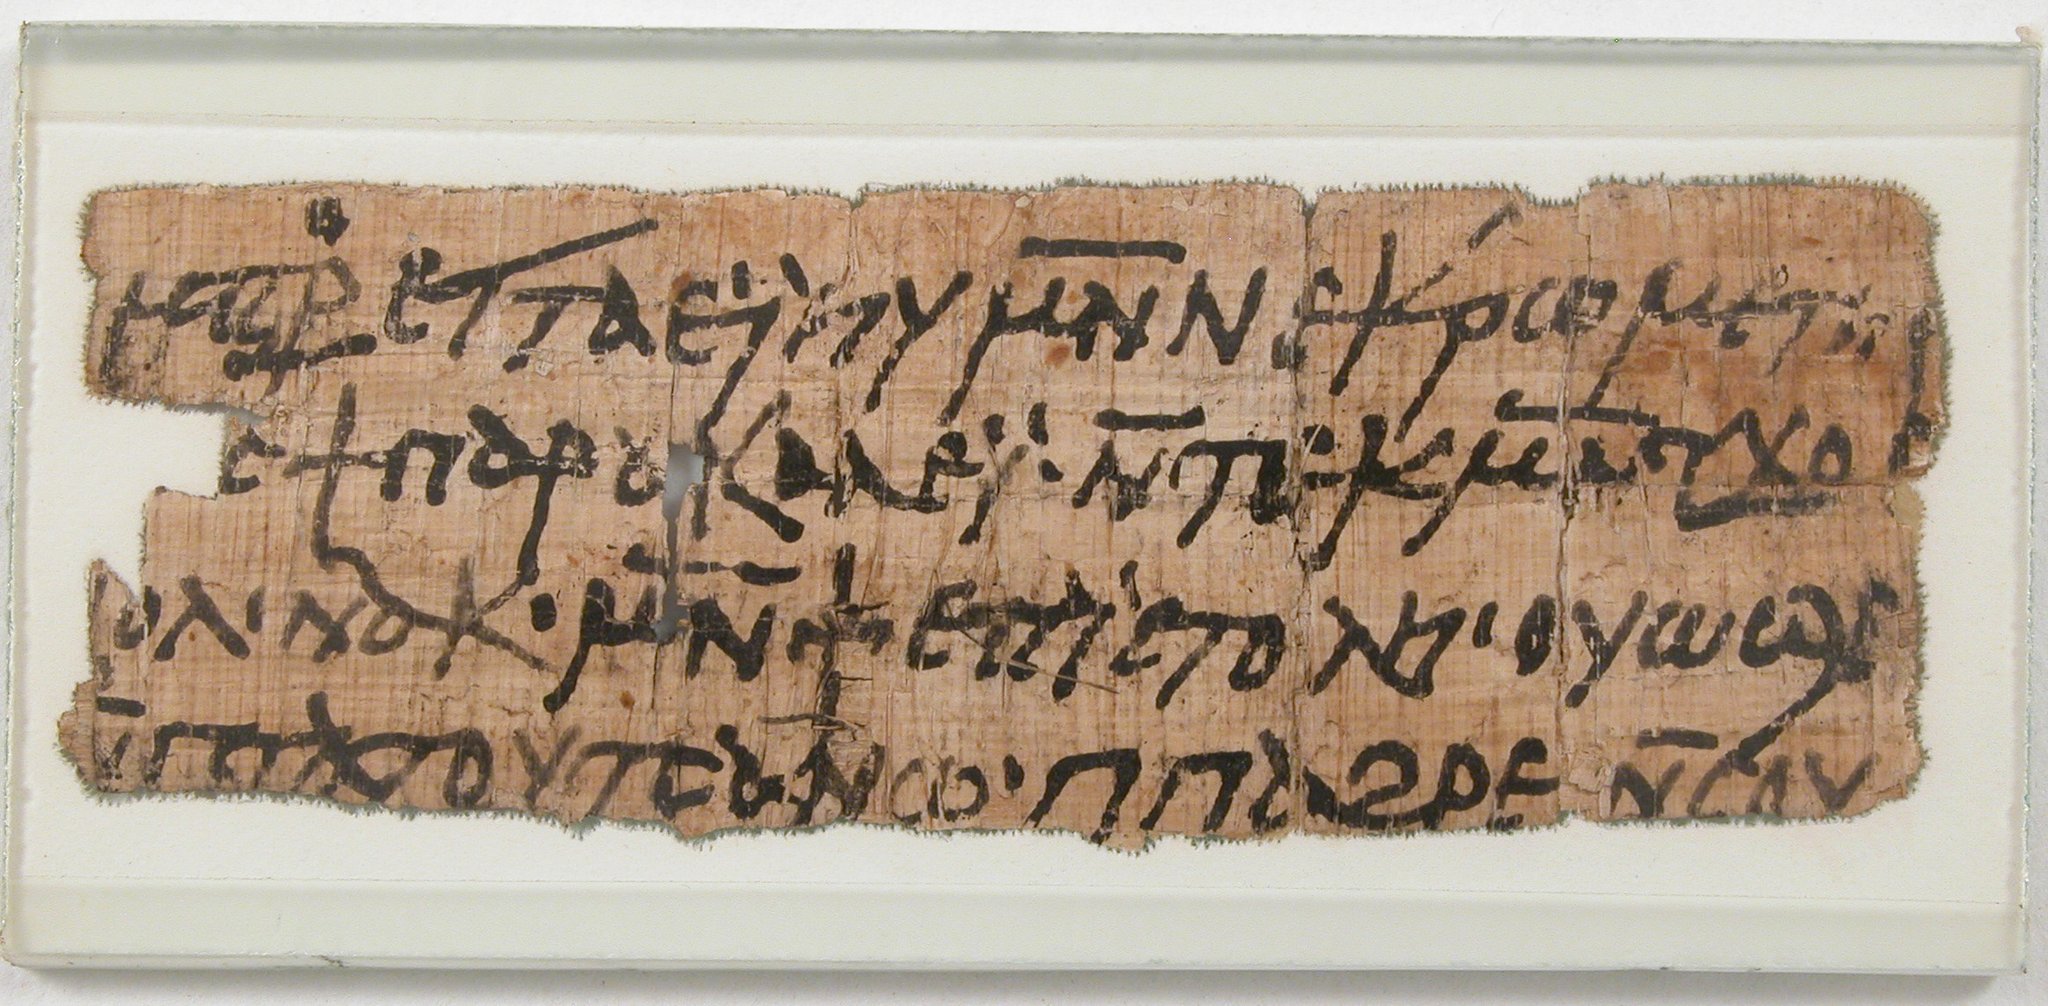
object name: fragment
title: Papyrus Fragment of a Letter to George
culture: coptic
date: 601-700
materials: ink, papyrus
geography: egypt